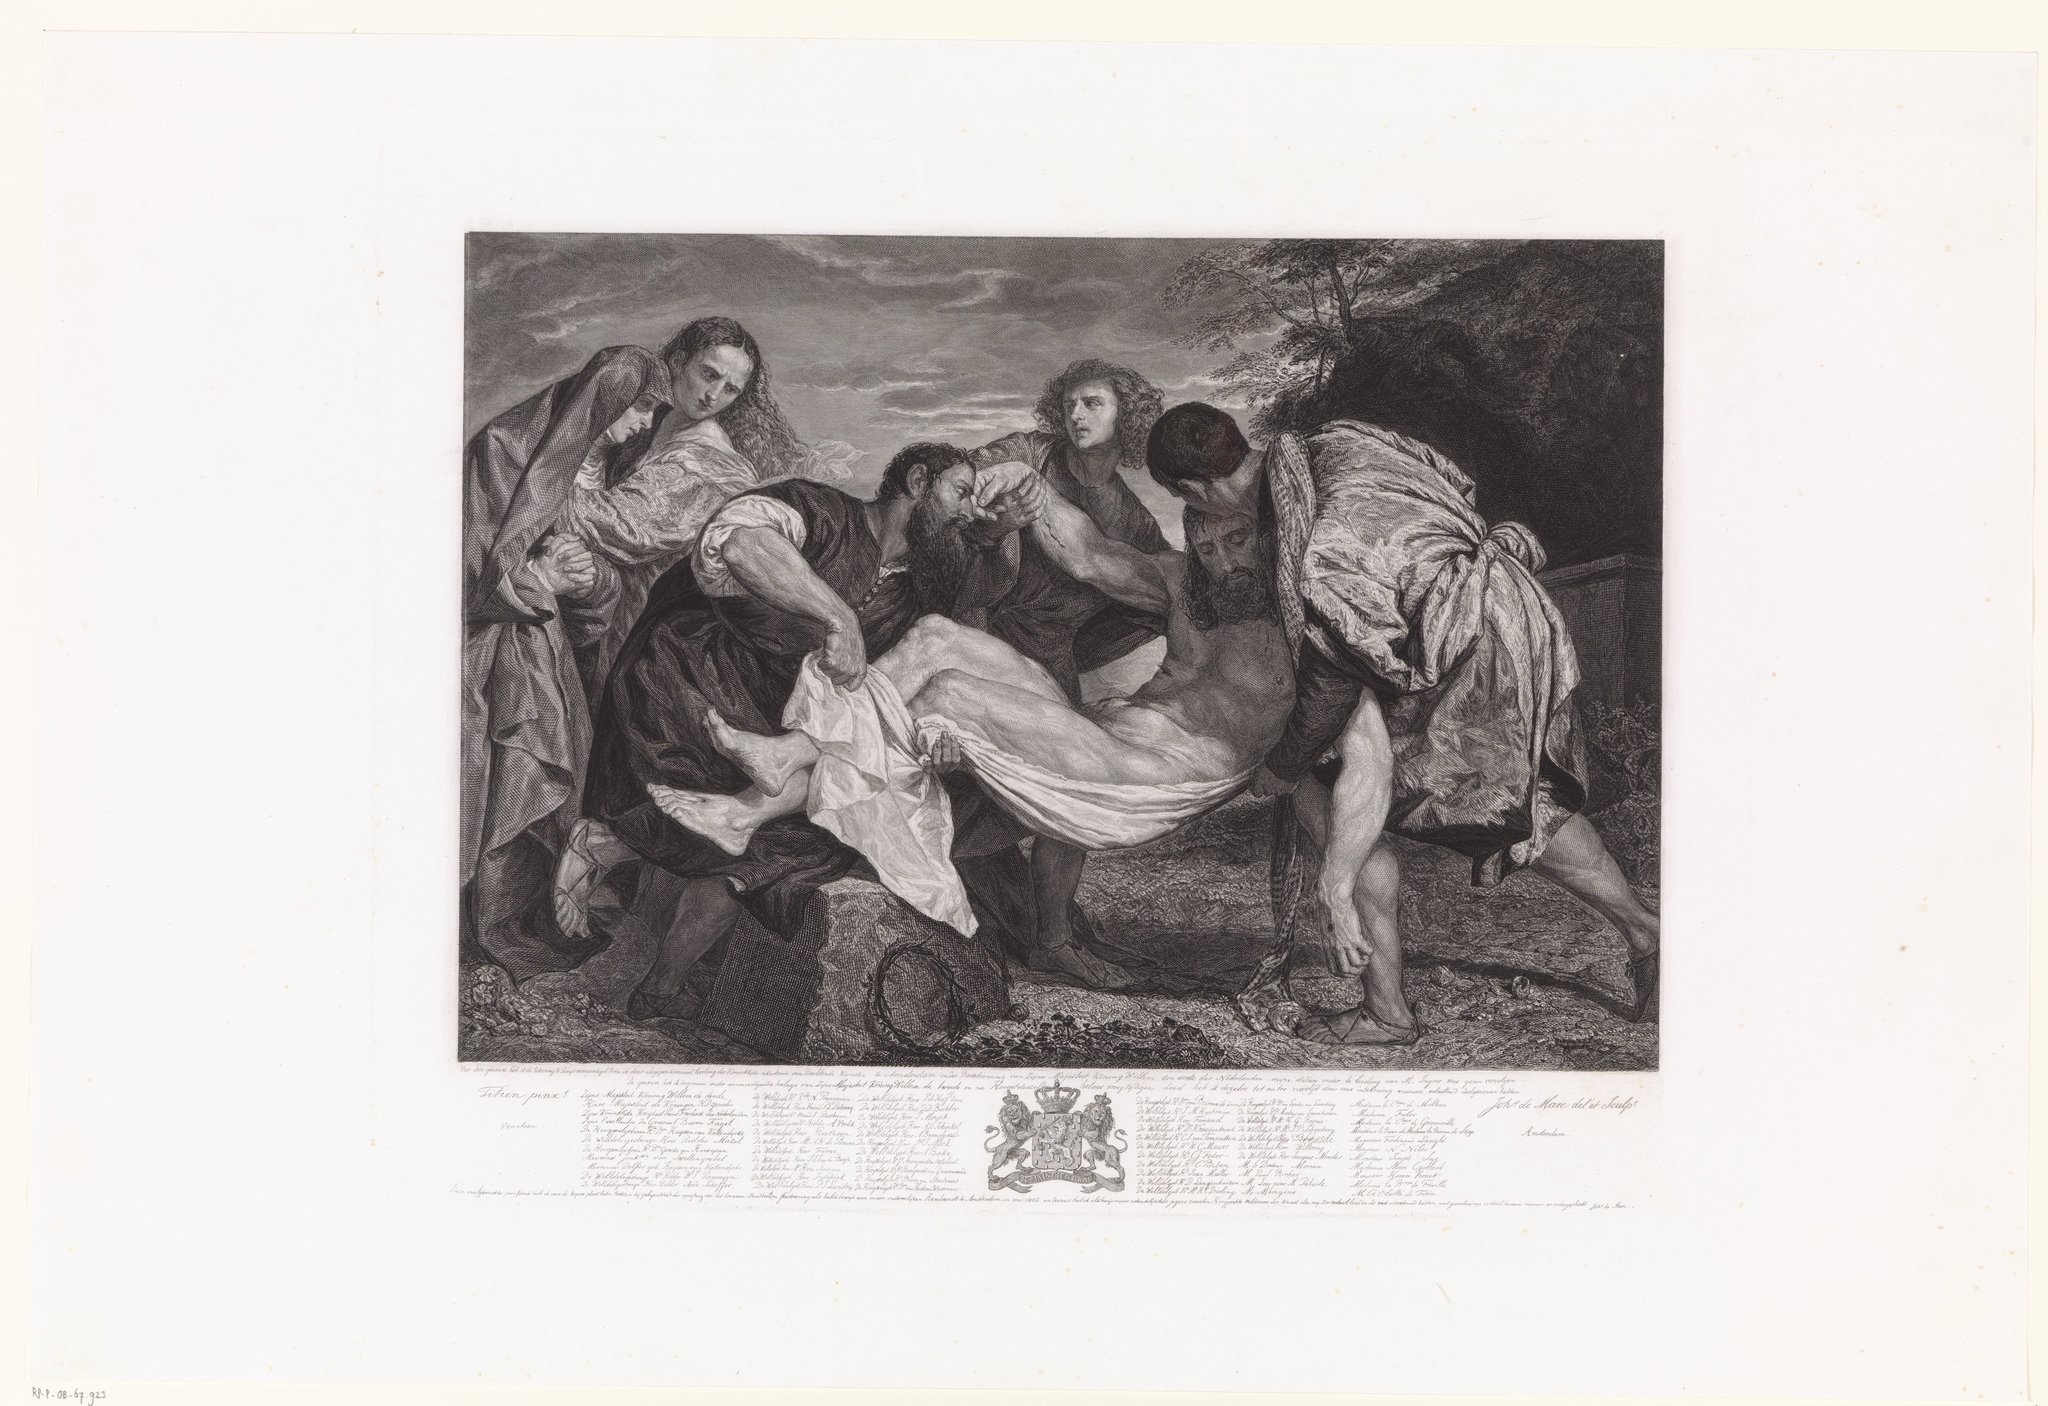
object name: print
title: Graflegging van Christus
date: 1805-1852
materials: paper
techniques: engraving, etching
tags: christ's entombment (possibly by angels)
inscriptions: collector's mark: Lugt 12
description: De graflegging van Christus. Het lichaam van Christus wordt naar het graf gedragen door Jozef van Aritmathea, Nicodemus en een derde discipel. Johannes ondersteunt de Maria.